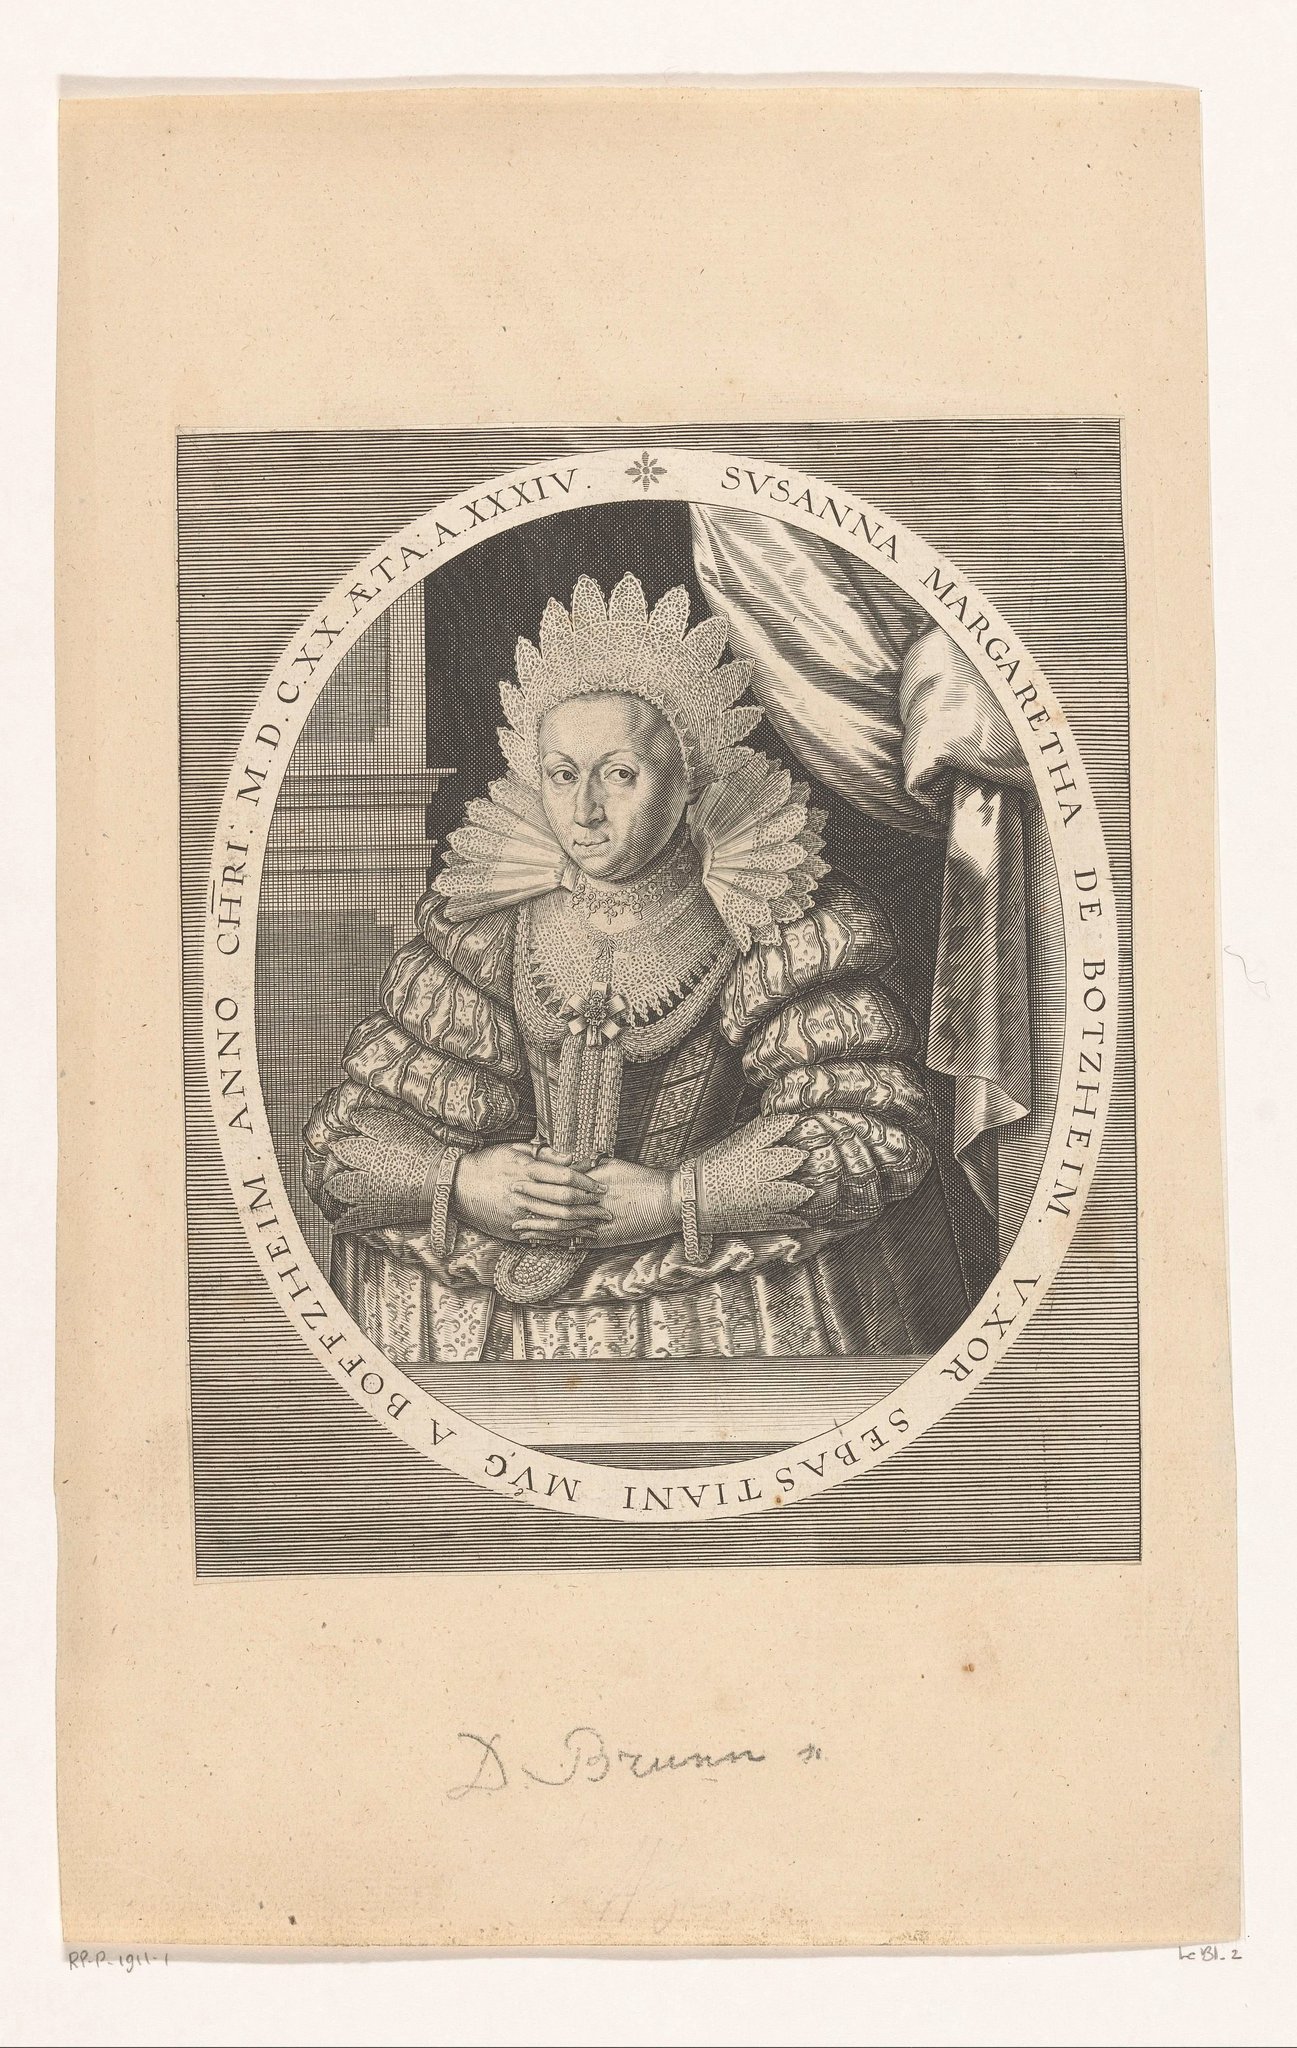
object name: print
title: Portret van Susanna Margaretha de Botzheim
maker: d. brunn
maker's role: print maker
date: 1620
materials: paper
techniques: engraving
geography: straatsburg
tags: historical persons - bb - woman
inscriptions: collector's mark: Lugt 2228